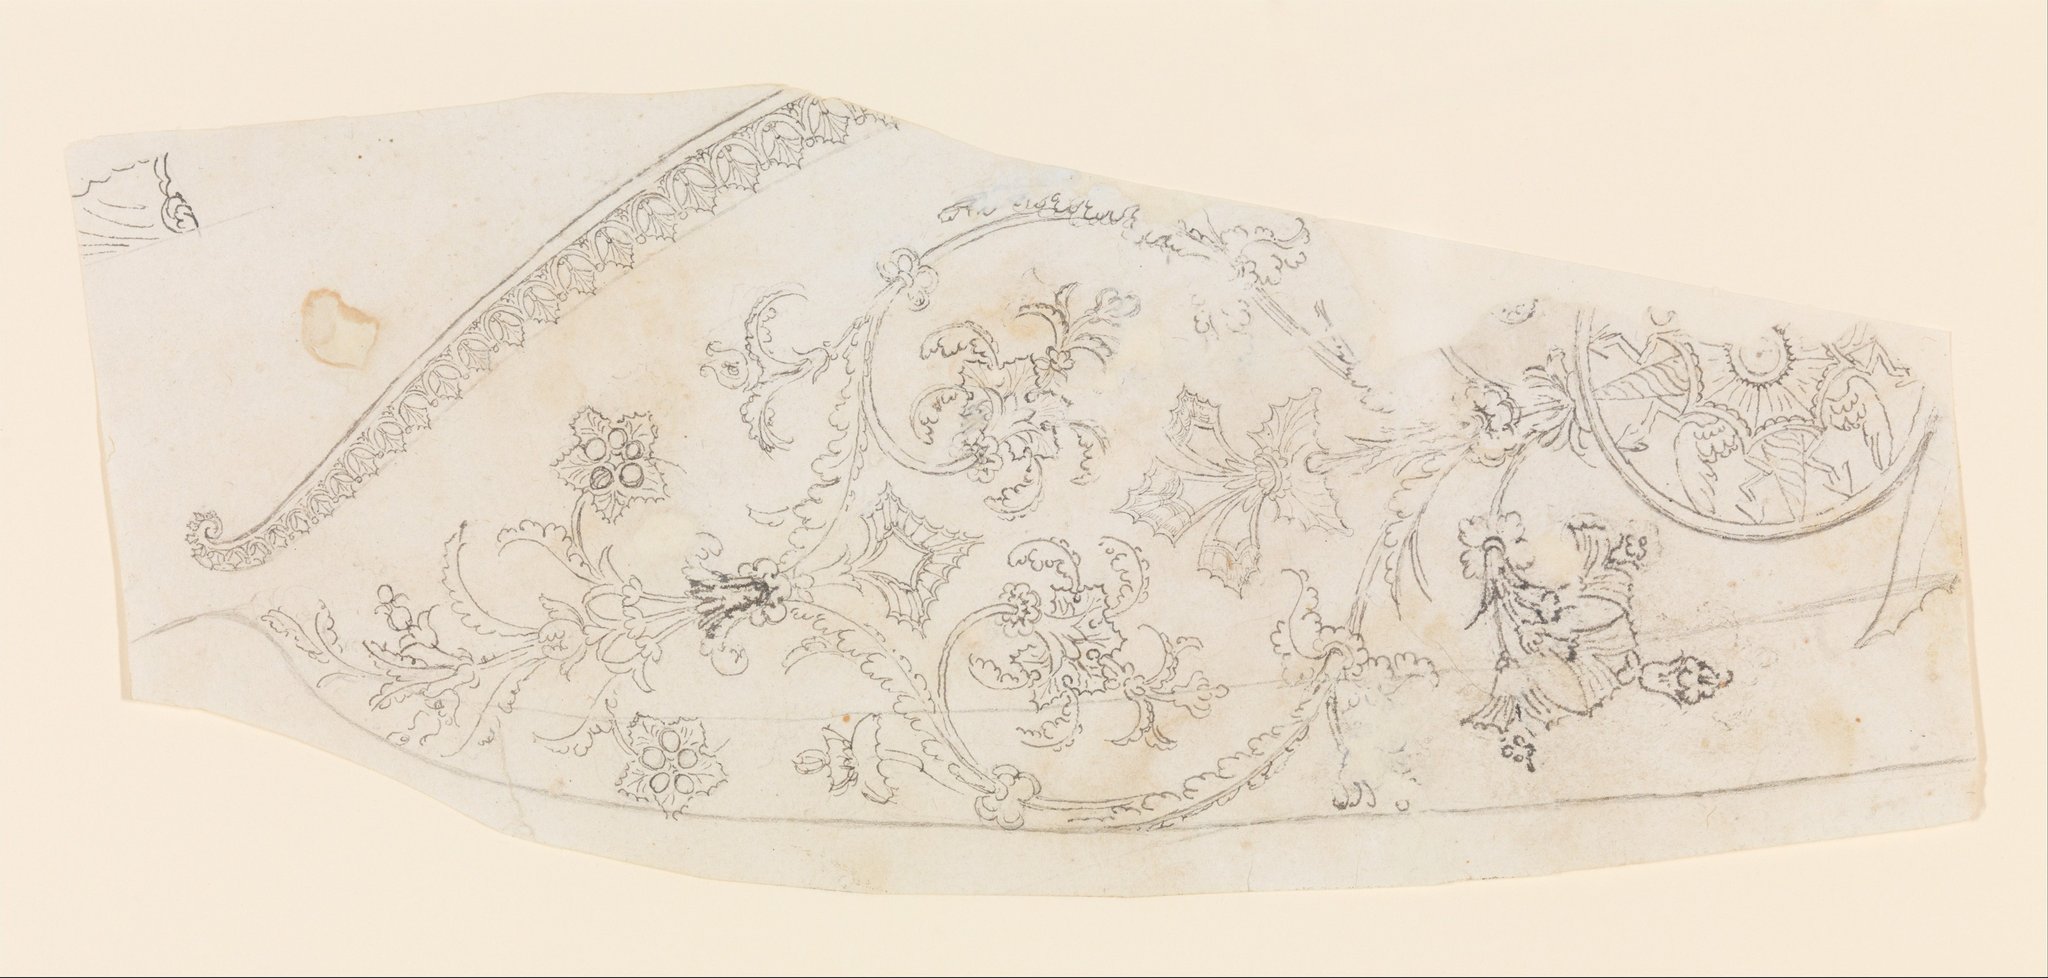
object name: drawing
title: Design for the Decoration of a Gun Stock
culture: french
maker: nicolas noël boutet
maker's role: designer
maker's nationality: french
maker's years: 1761-1833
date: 1795-1805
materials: ink, paper, pencil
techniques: wash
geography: france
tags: flowers,leaves